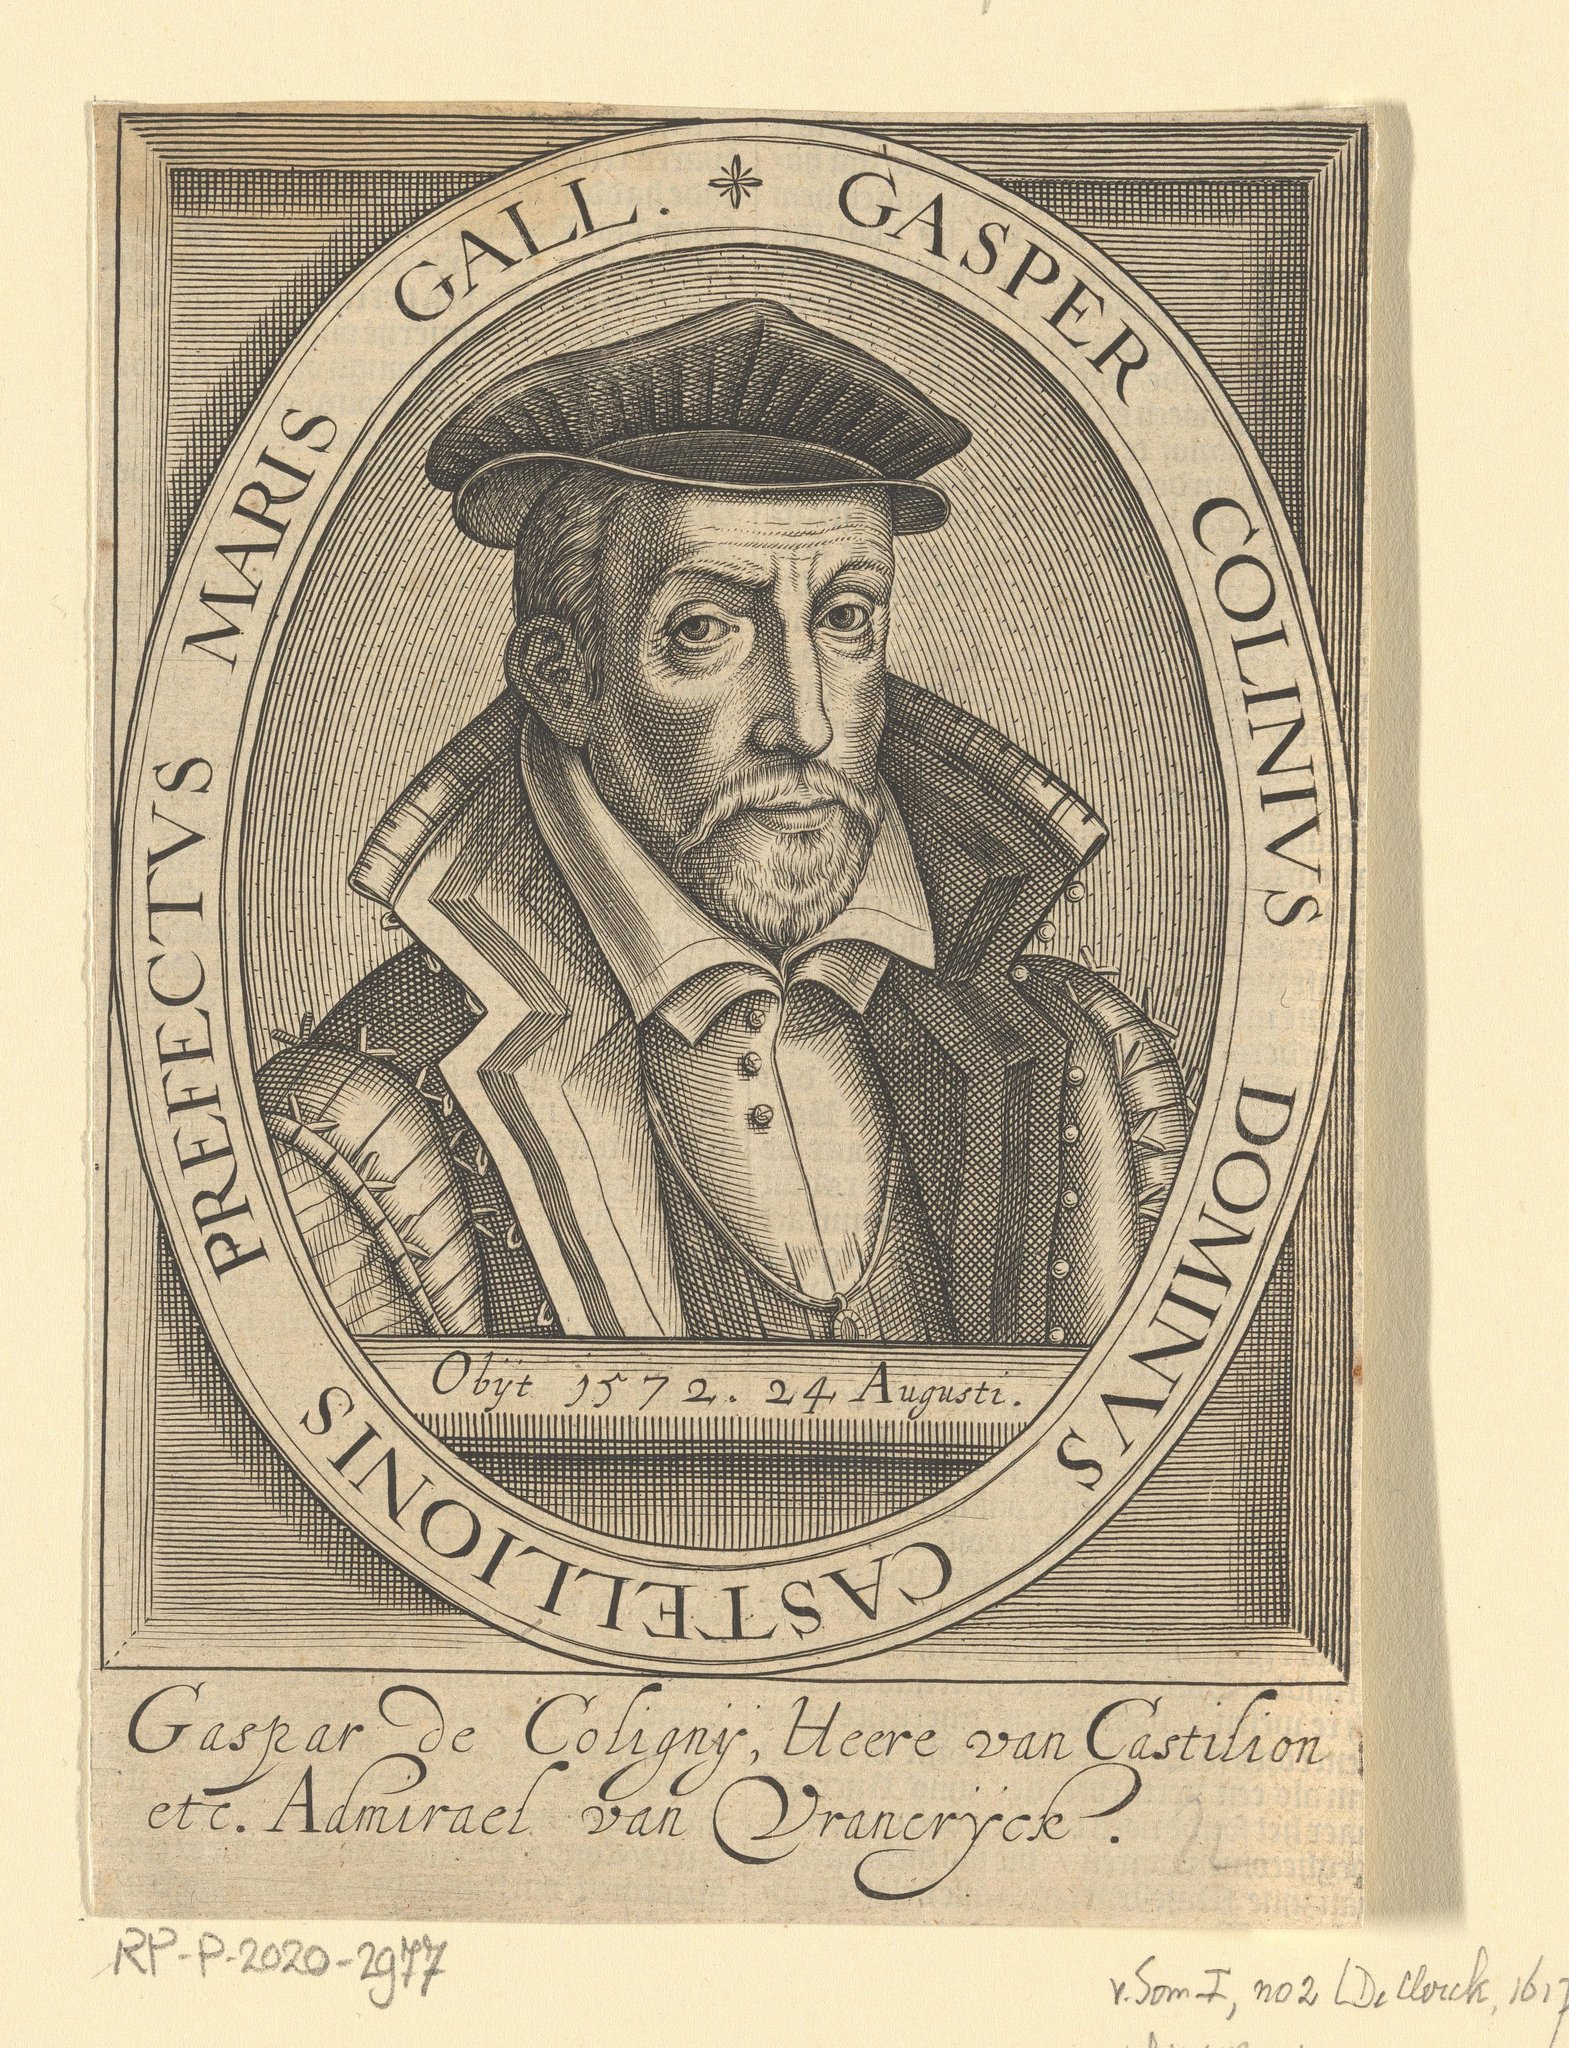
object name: print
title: Portret van Gaspard de Coligny II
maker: Anonymous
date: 1625-1674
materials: paper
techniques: engraving, letterpress printing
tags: paris, politician, gaspard de coligny (ii), historical persons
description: Prent mogelijk gebruikt in meerdere edities en vertalingen van Emanuel van Meterens 'Nederlantsche historien'.